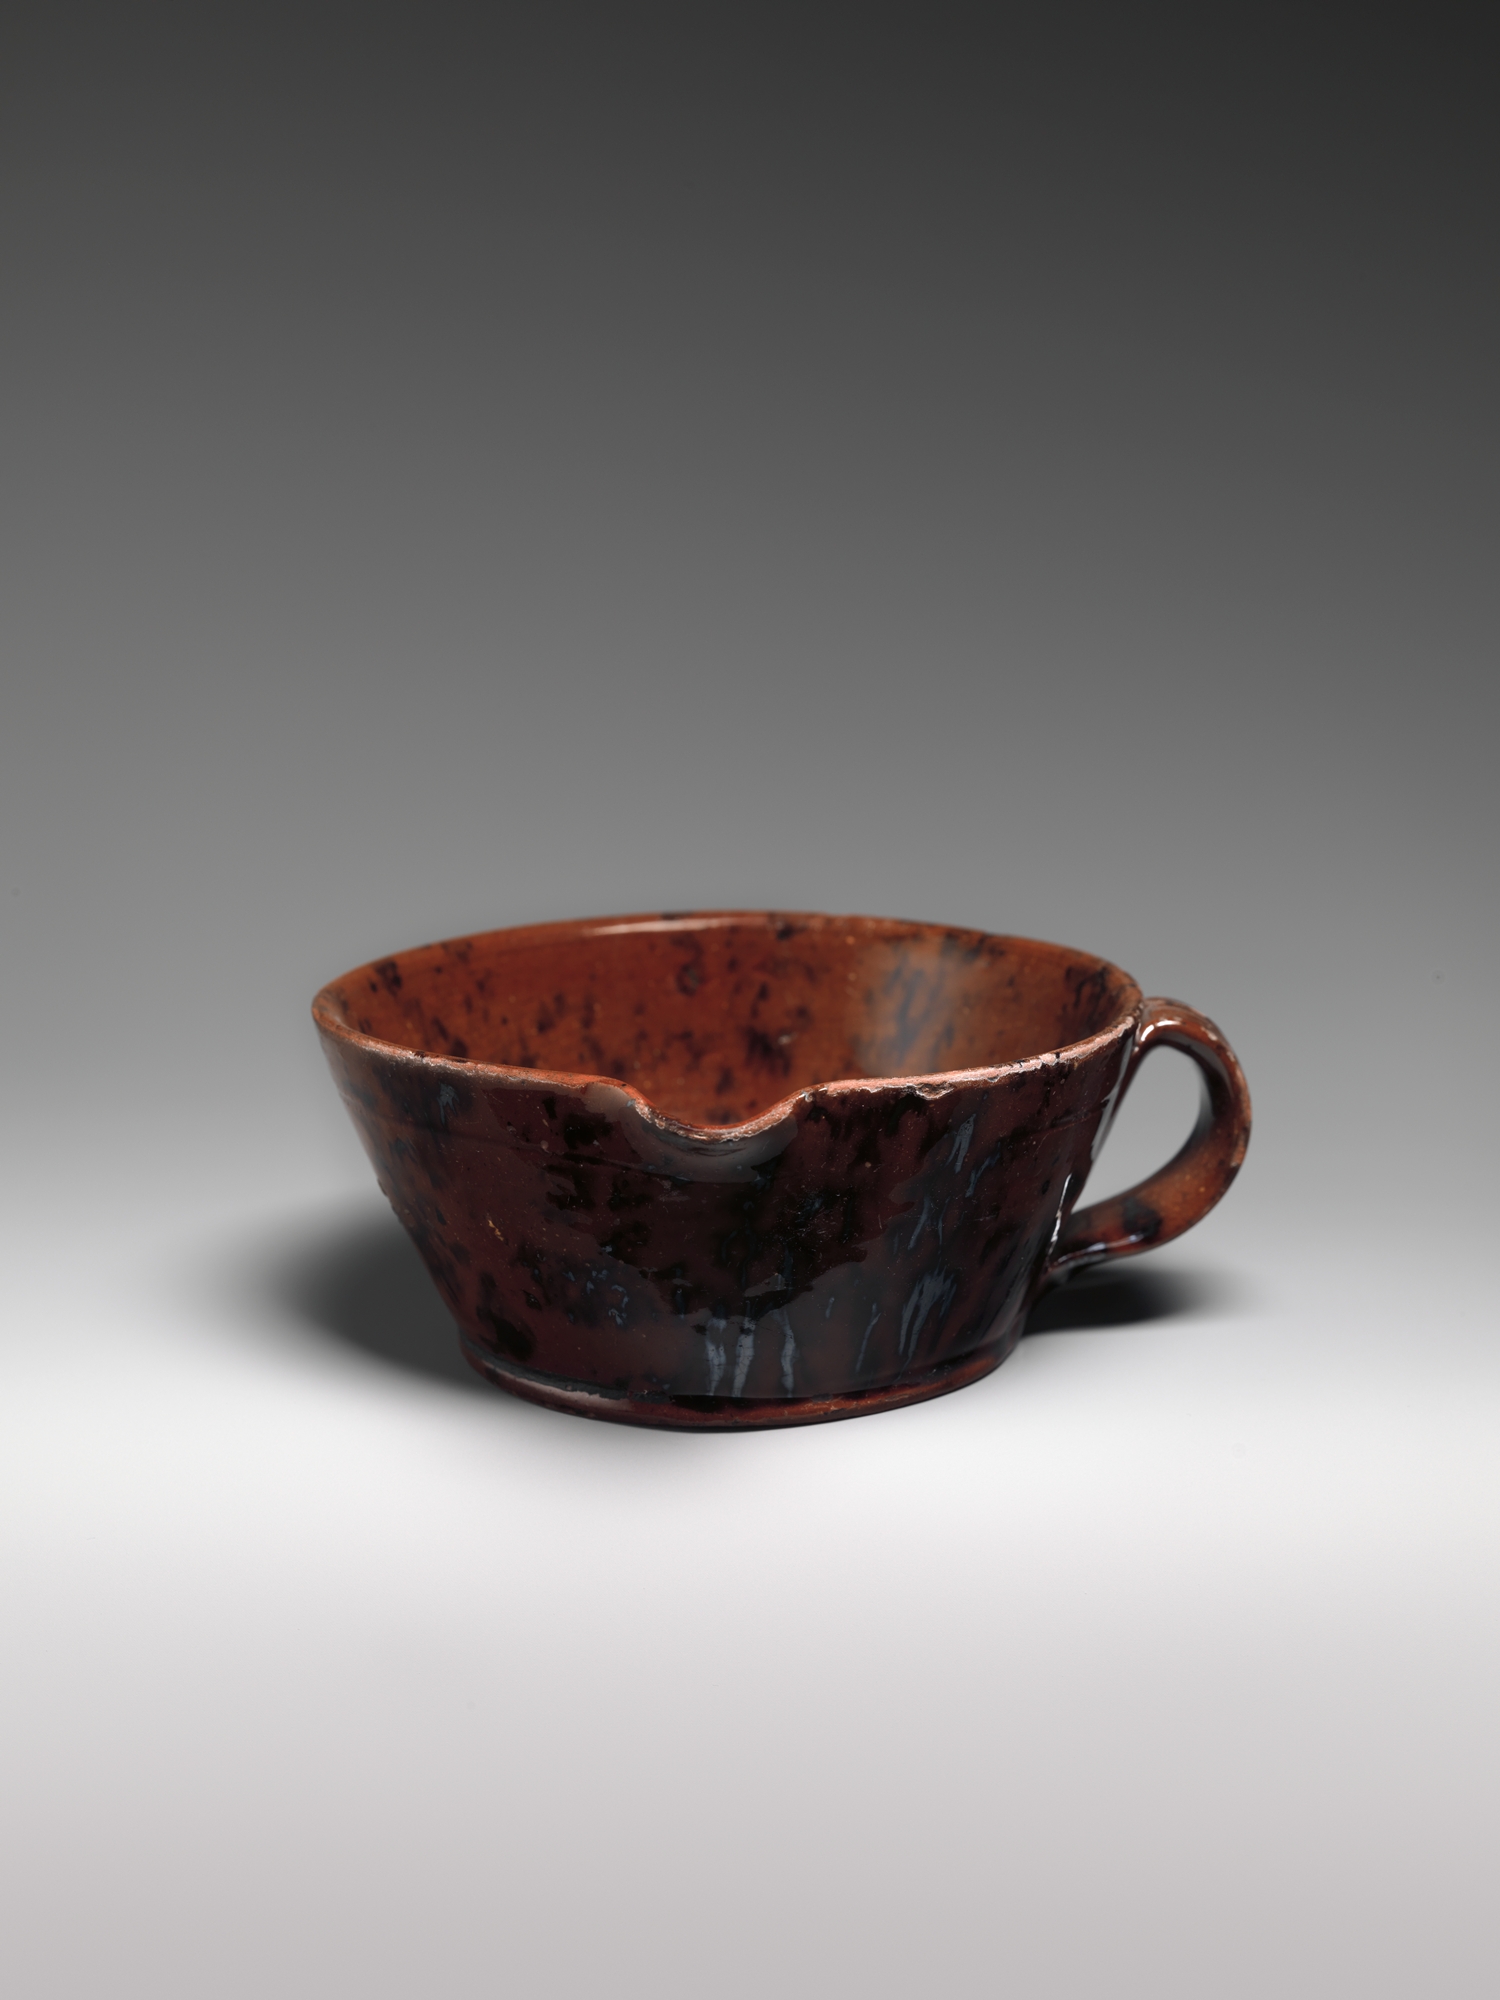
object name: dish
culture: american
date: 1850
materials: earthenware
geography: united states